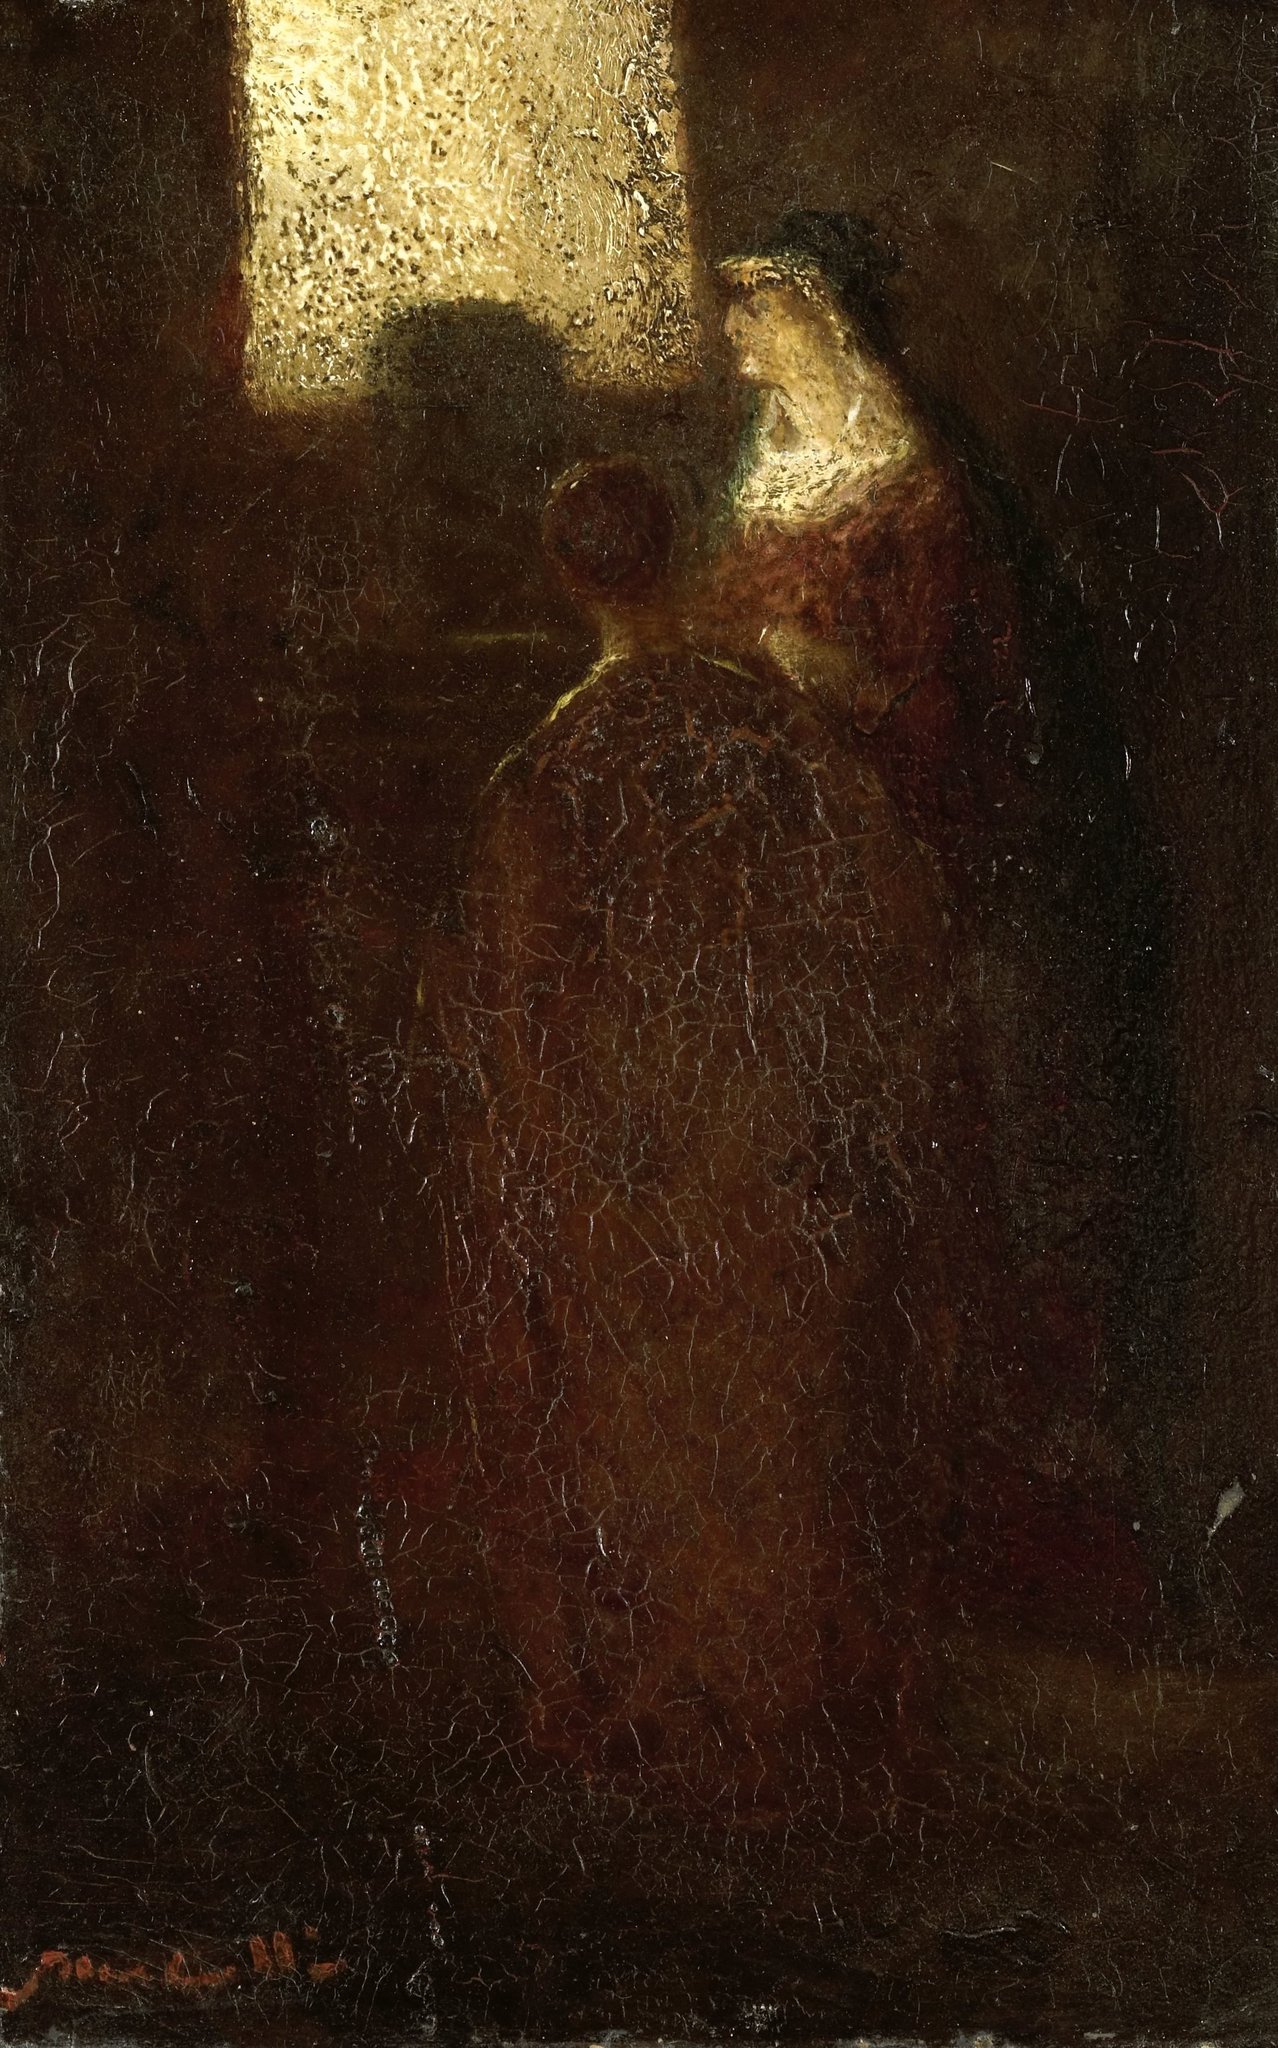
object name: painting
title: Aan het altaar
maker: adolphe joseph thomas monticelli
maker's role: painter, print maker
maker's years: 1824-1886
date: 1870-1886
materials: cardboard, oil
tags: interior of church, altar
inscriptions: signature: ‘Monticelli’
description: Een man en vrouw staande voor het altaar.